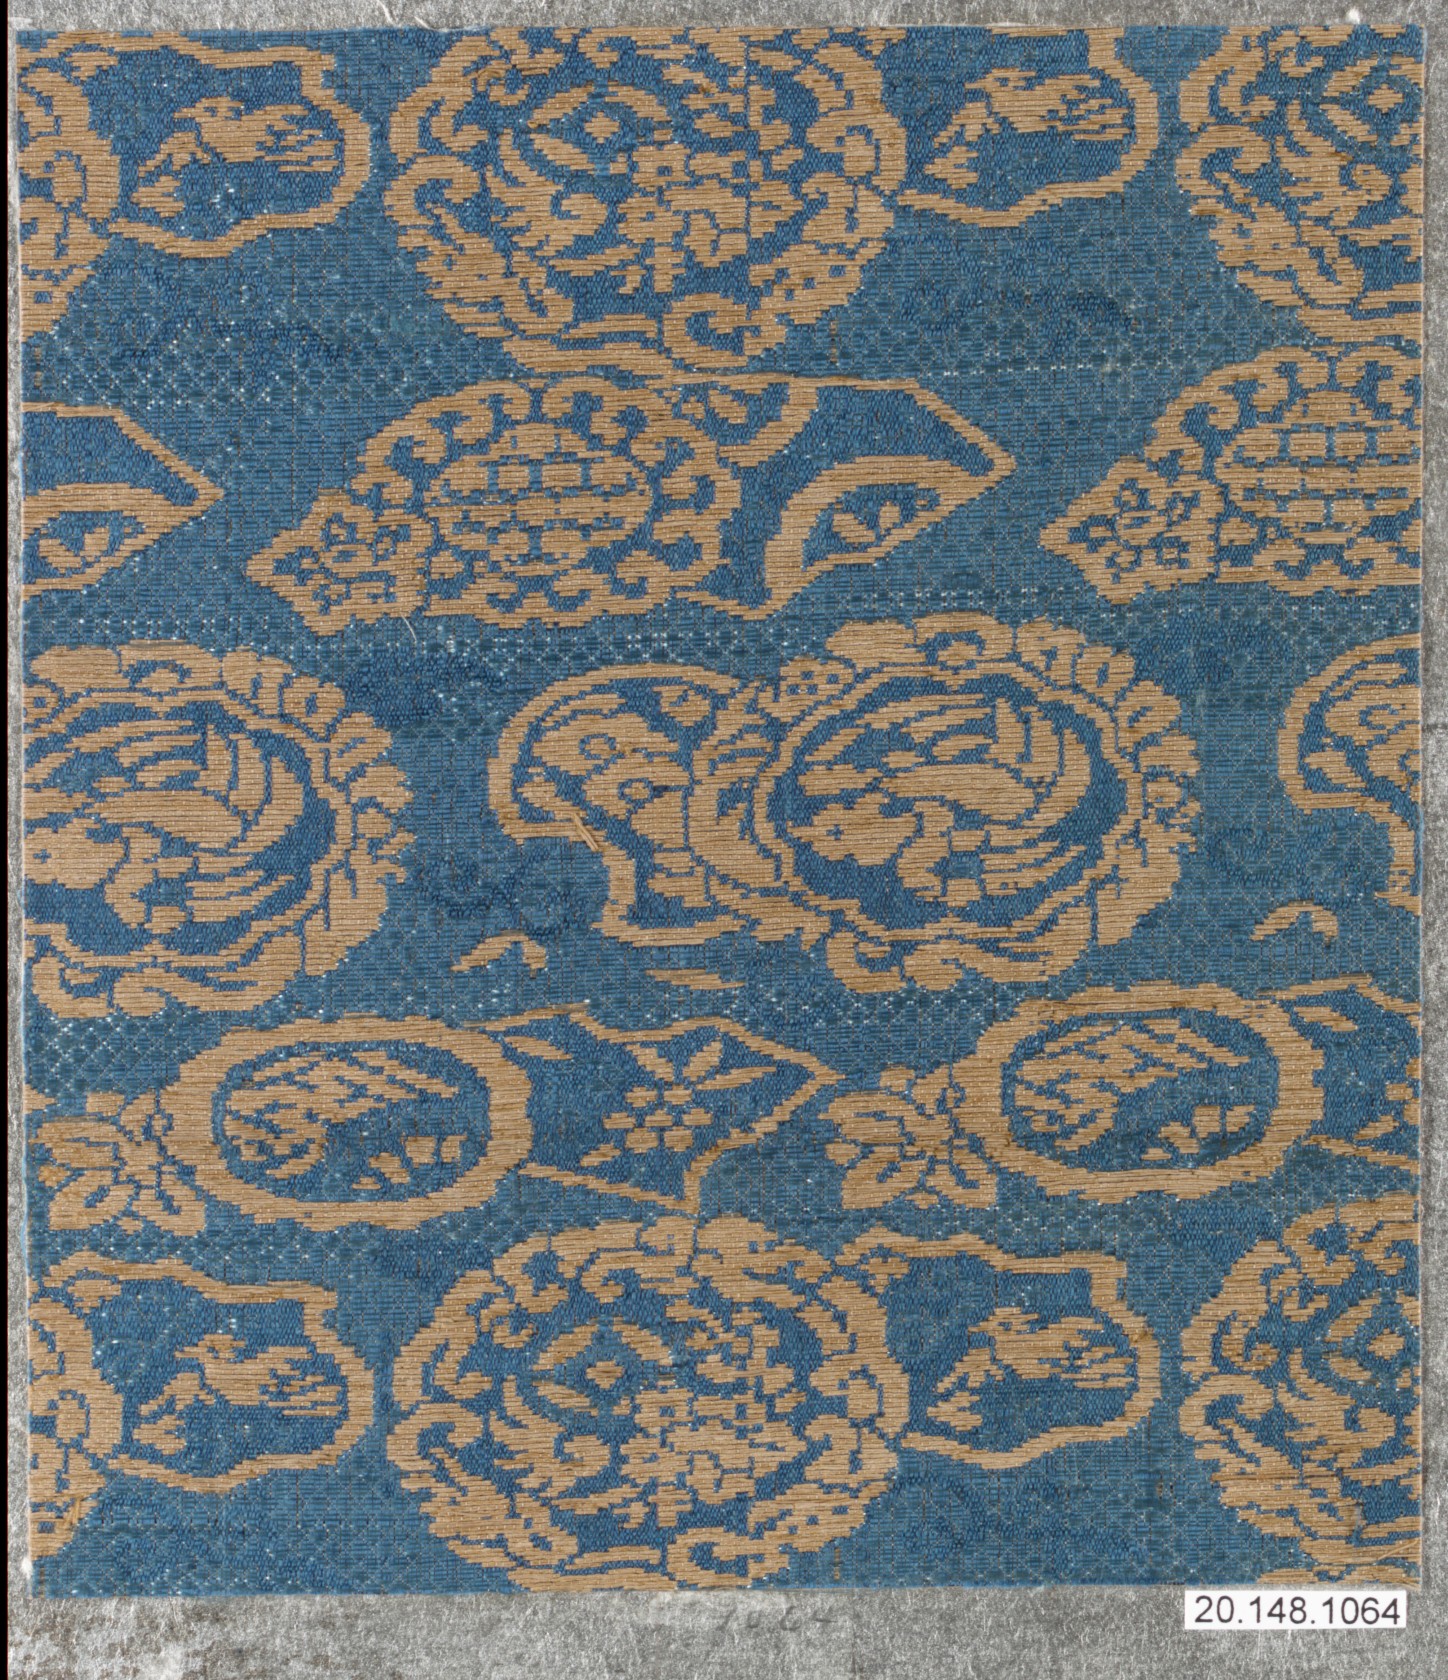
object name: piece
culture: china or japan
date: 1701-1800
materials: silk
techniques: compound weave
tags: birds